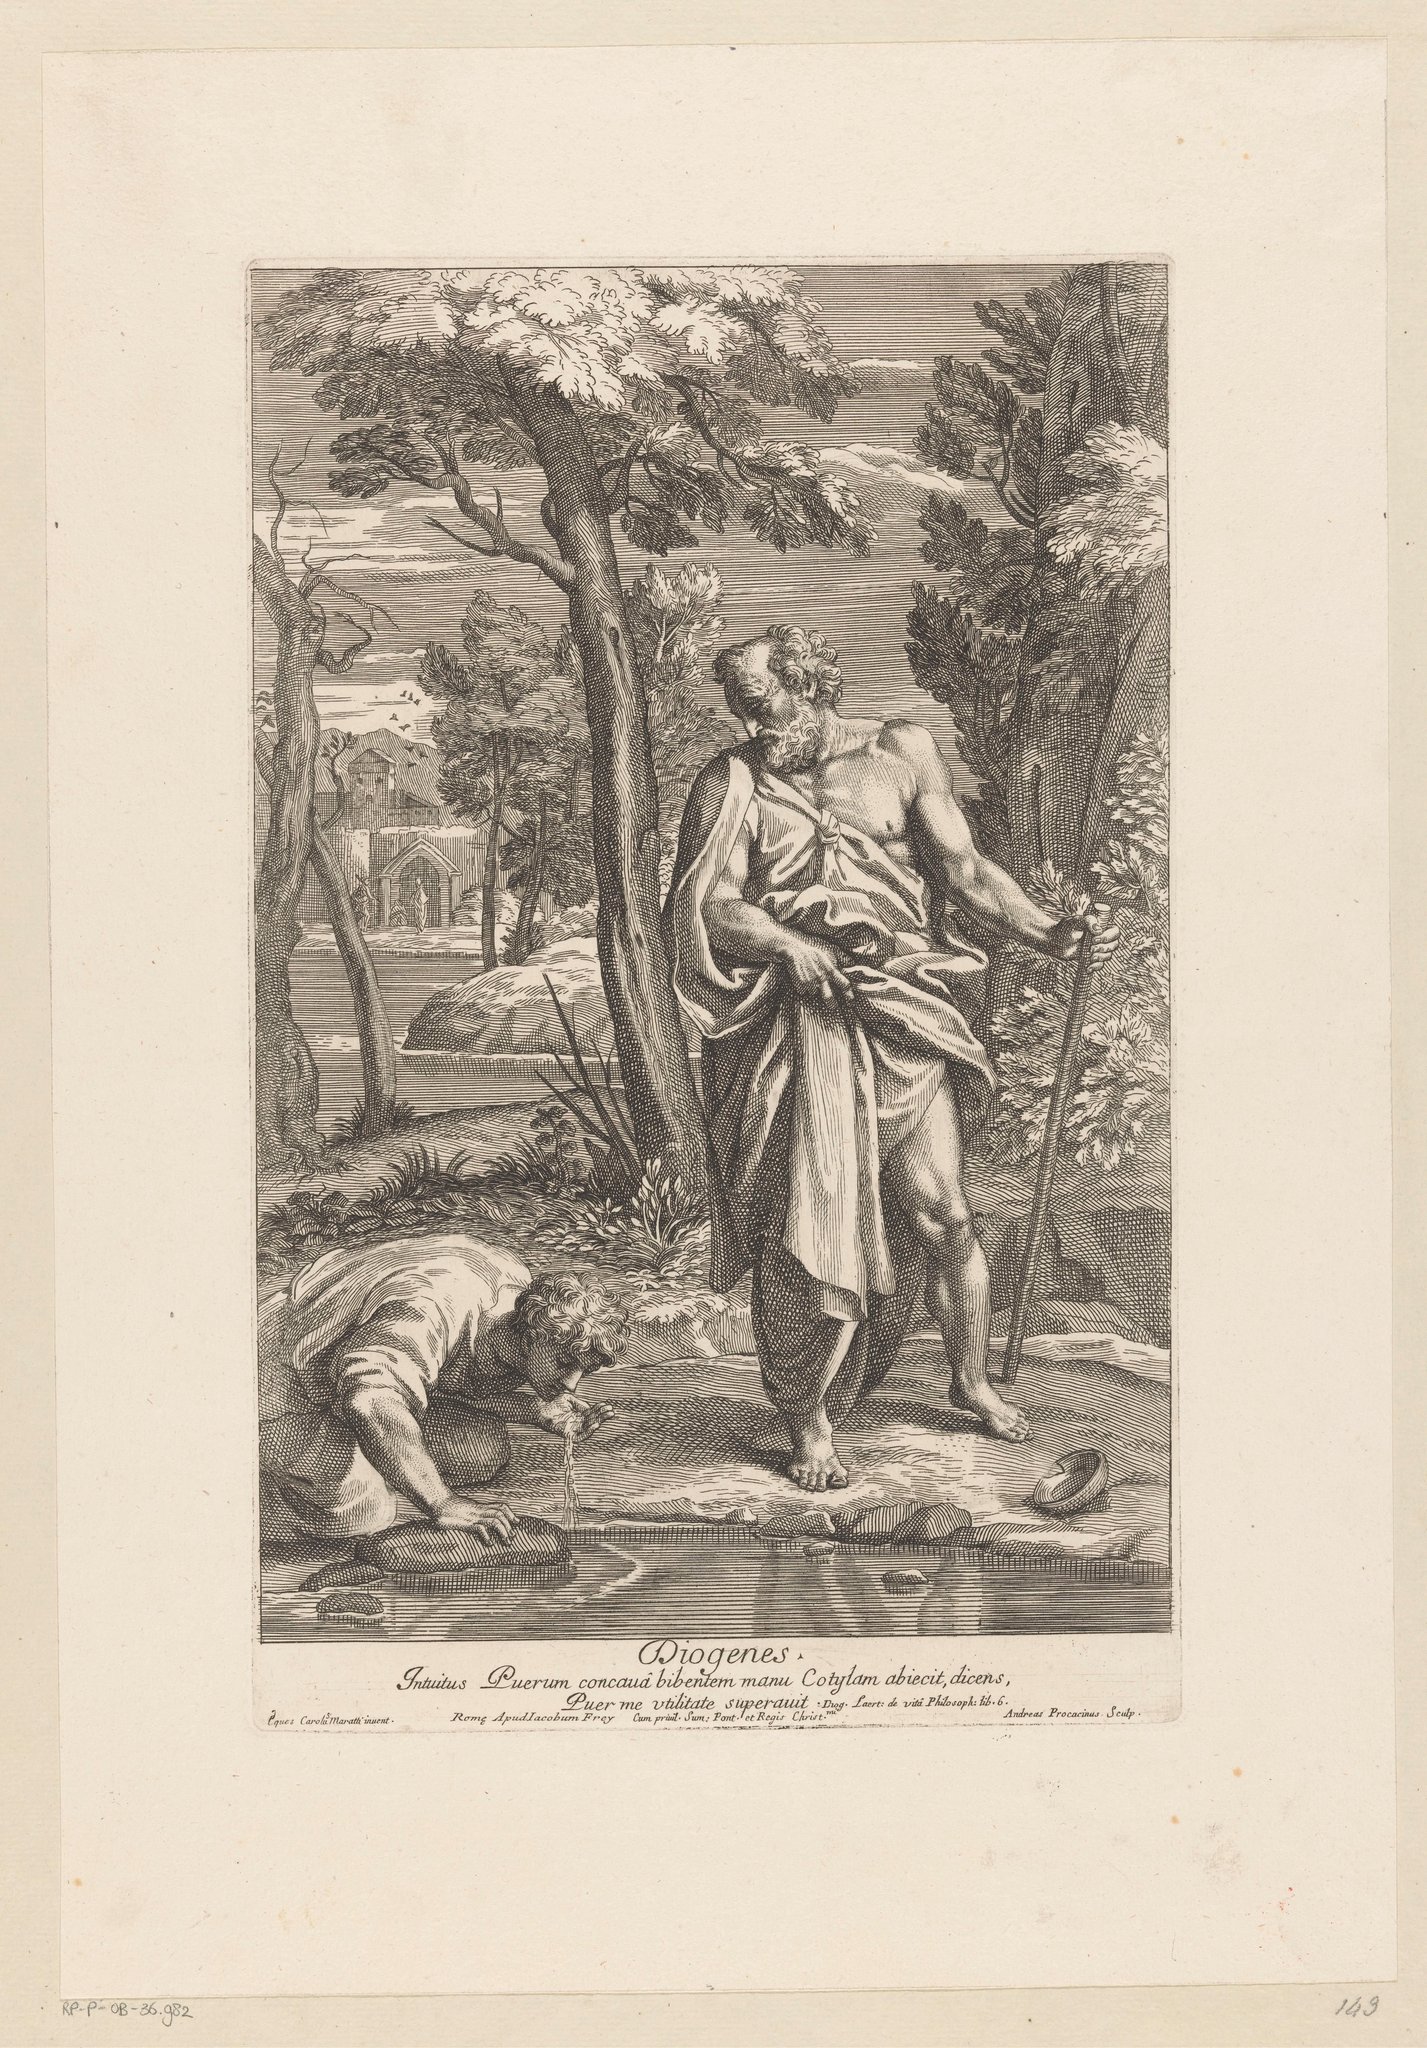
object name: print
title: Diogenes ziet een drinkende jongen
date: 1681-1734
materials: paper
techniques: etching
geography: rome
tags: diogenes throws away his drinking-cup on seeing a boy drink from his cupped hands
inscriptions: collector's mark: Lugt 240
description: Diogenes staat in een landschap. Hij kijkt omlaag naar een jongen die van zijn handen een kommetje maakt en daarmee water uit een plas drinkt. Bij de voeten van Diogenes ligt diens drinkbeker gebroken op de grond. Titel en onderschrift in het Latijn in ondermarge.